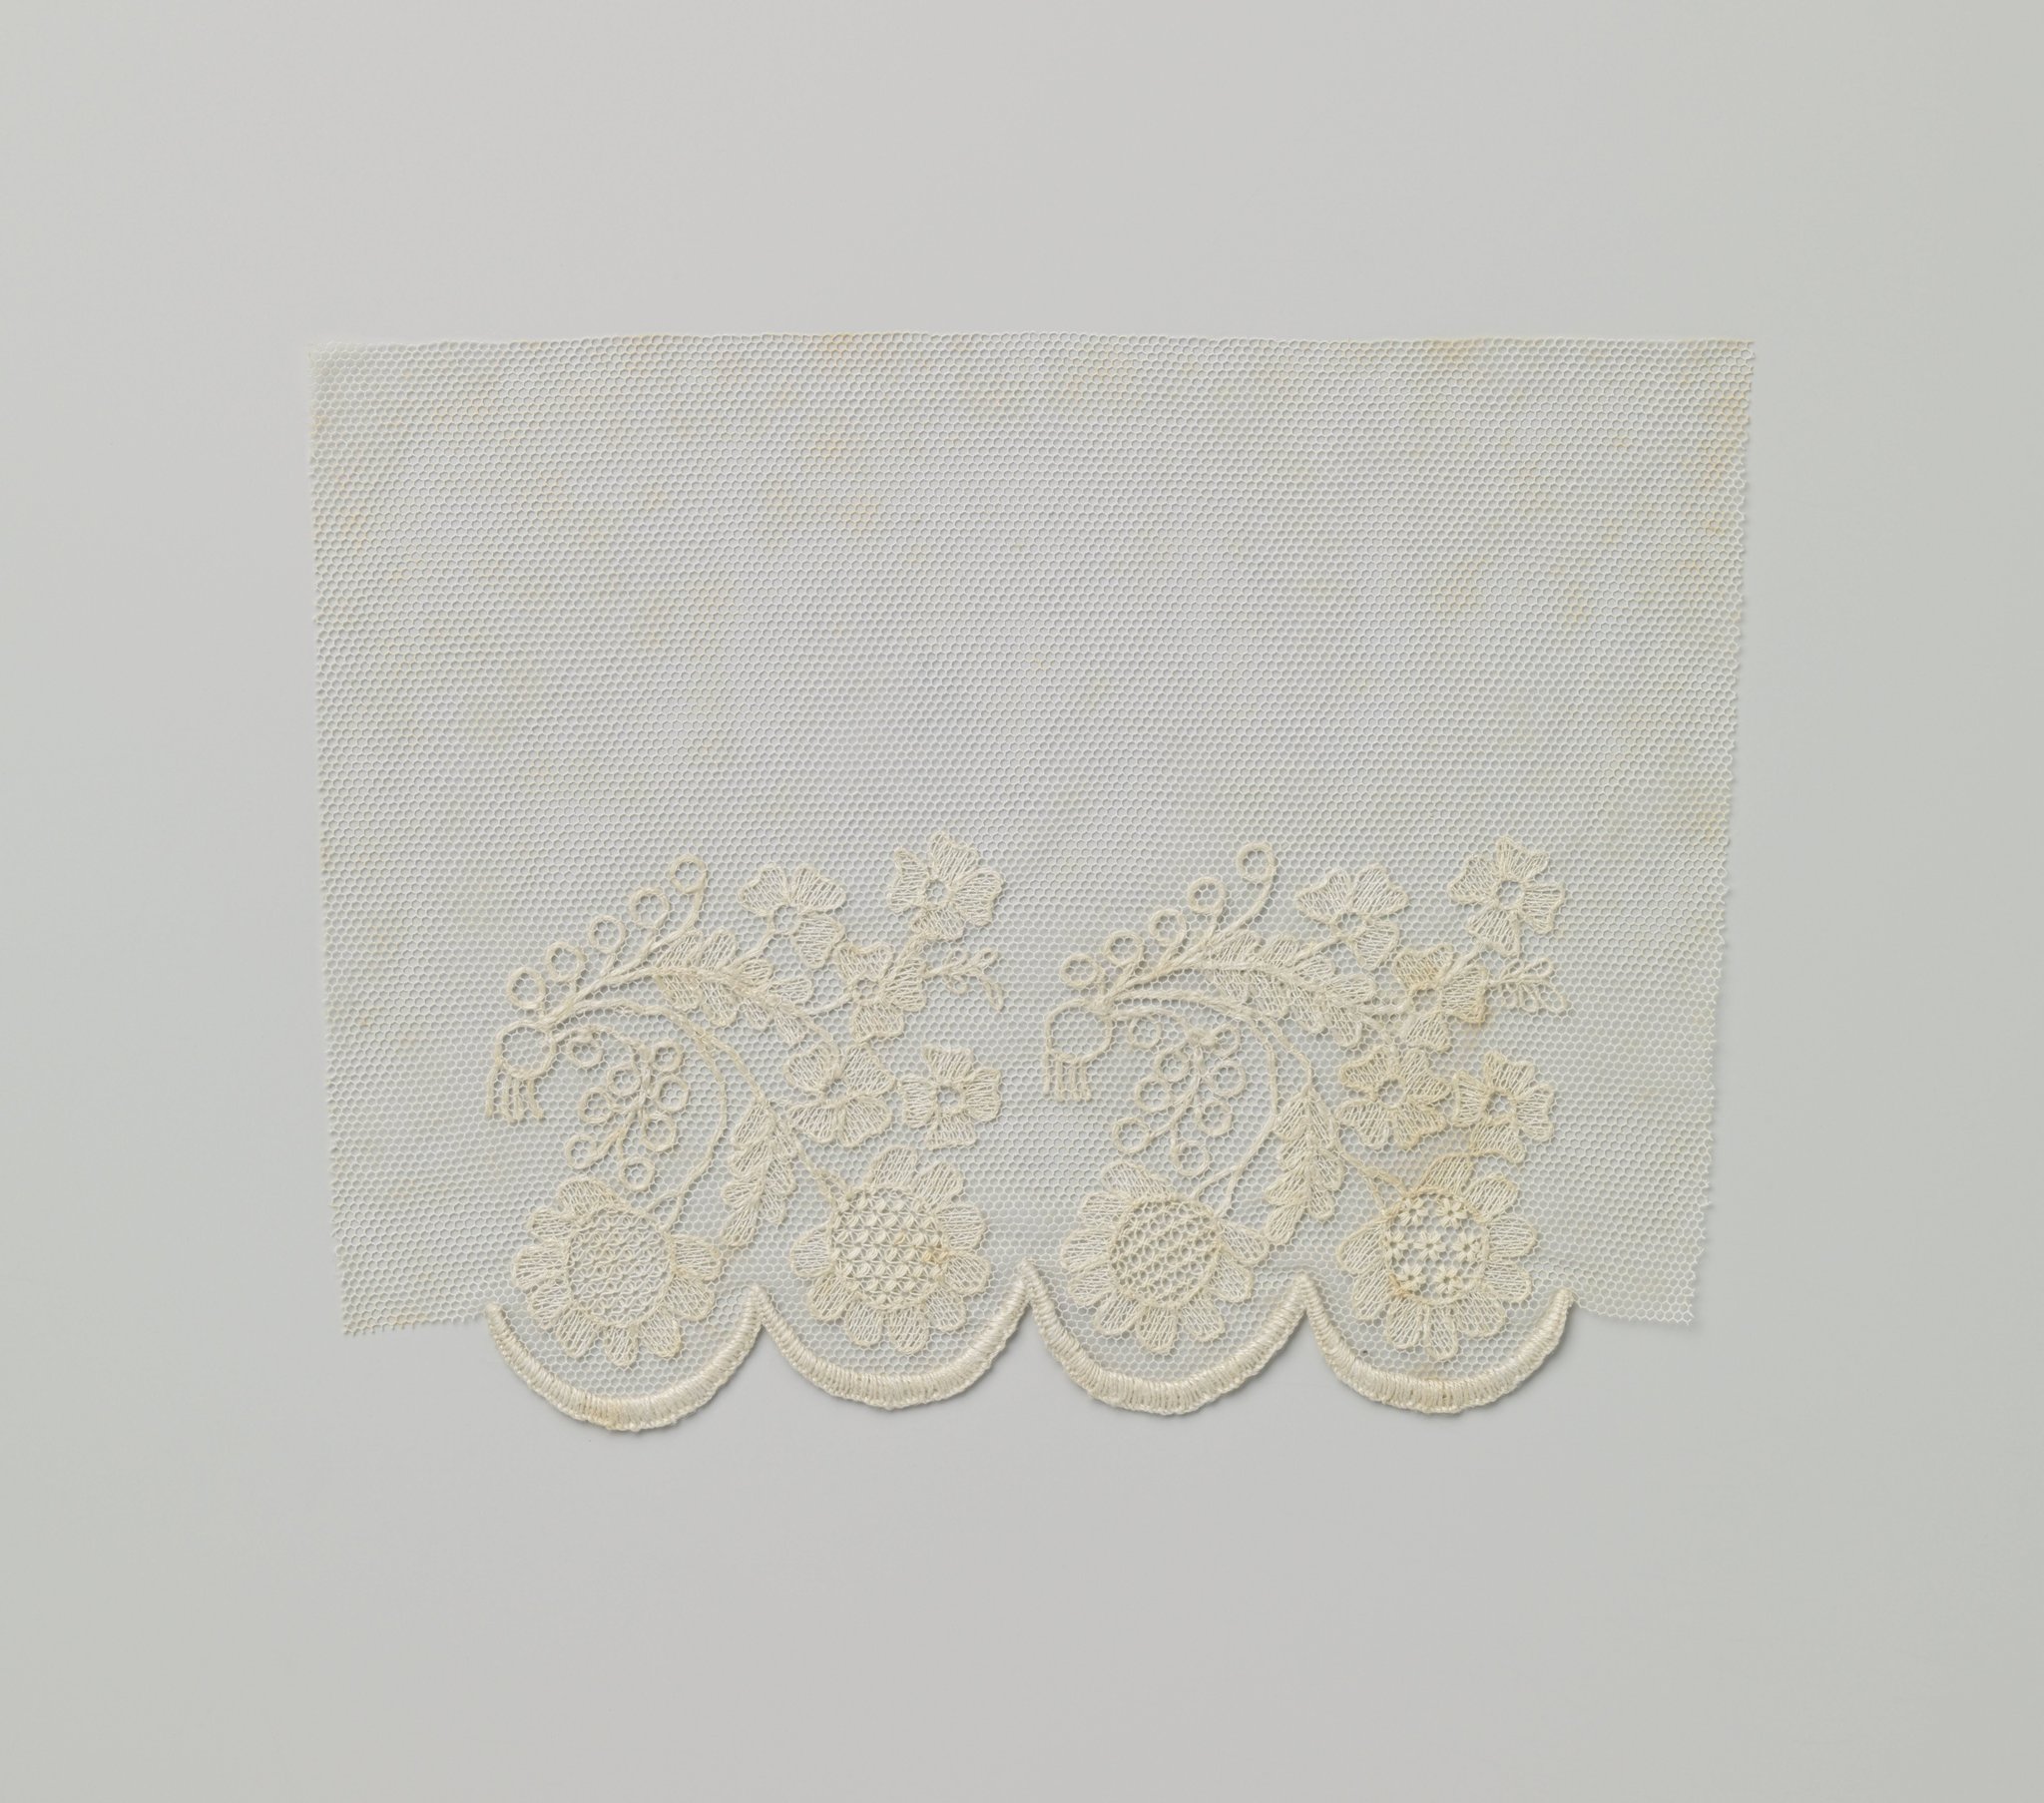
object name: werkstuk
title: Werkstuk voor Diploma fraaie handwerken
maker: geesje smid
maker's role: artisan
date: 1890-1900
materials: fiber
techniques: embroidered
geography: netherlands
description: Geschulpte strook tule doorstop met patroon van bloemtakjes.